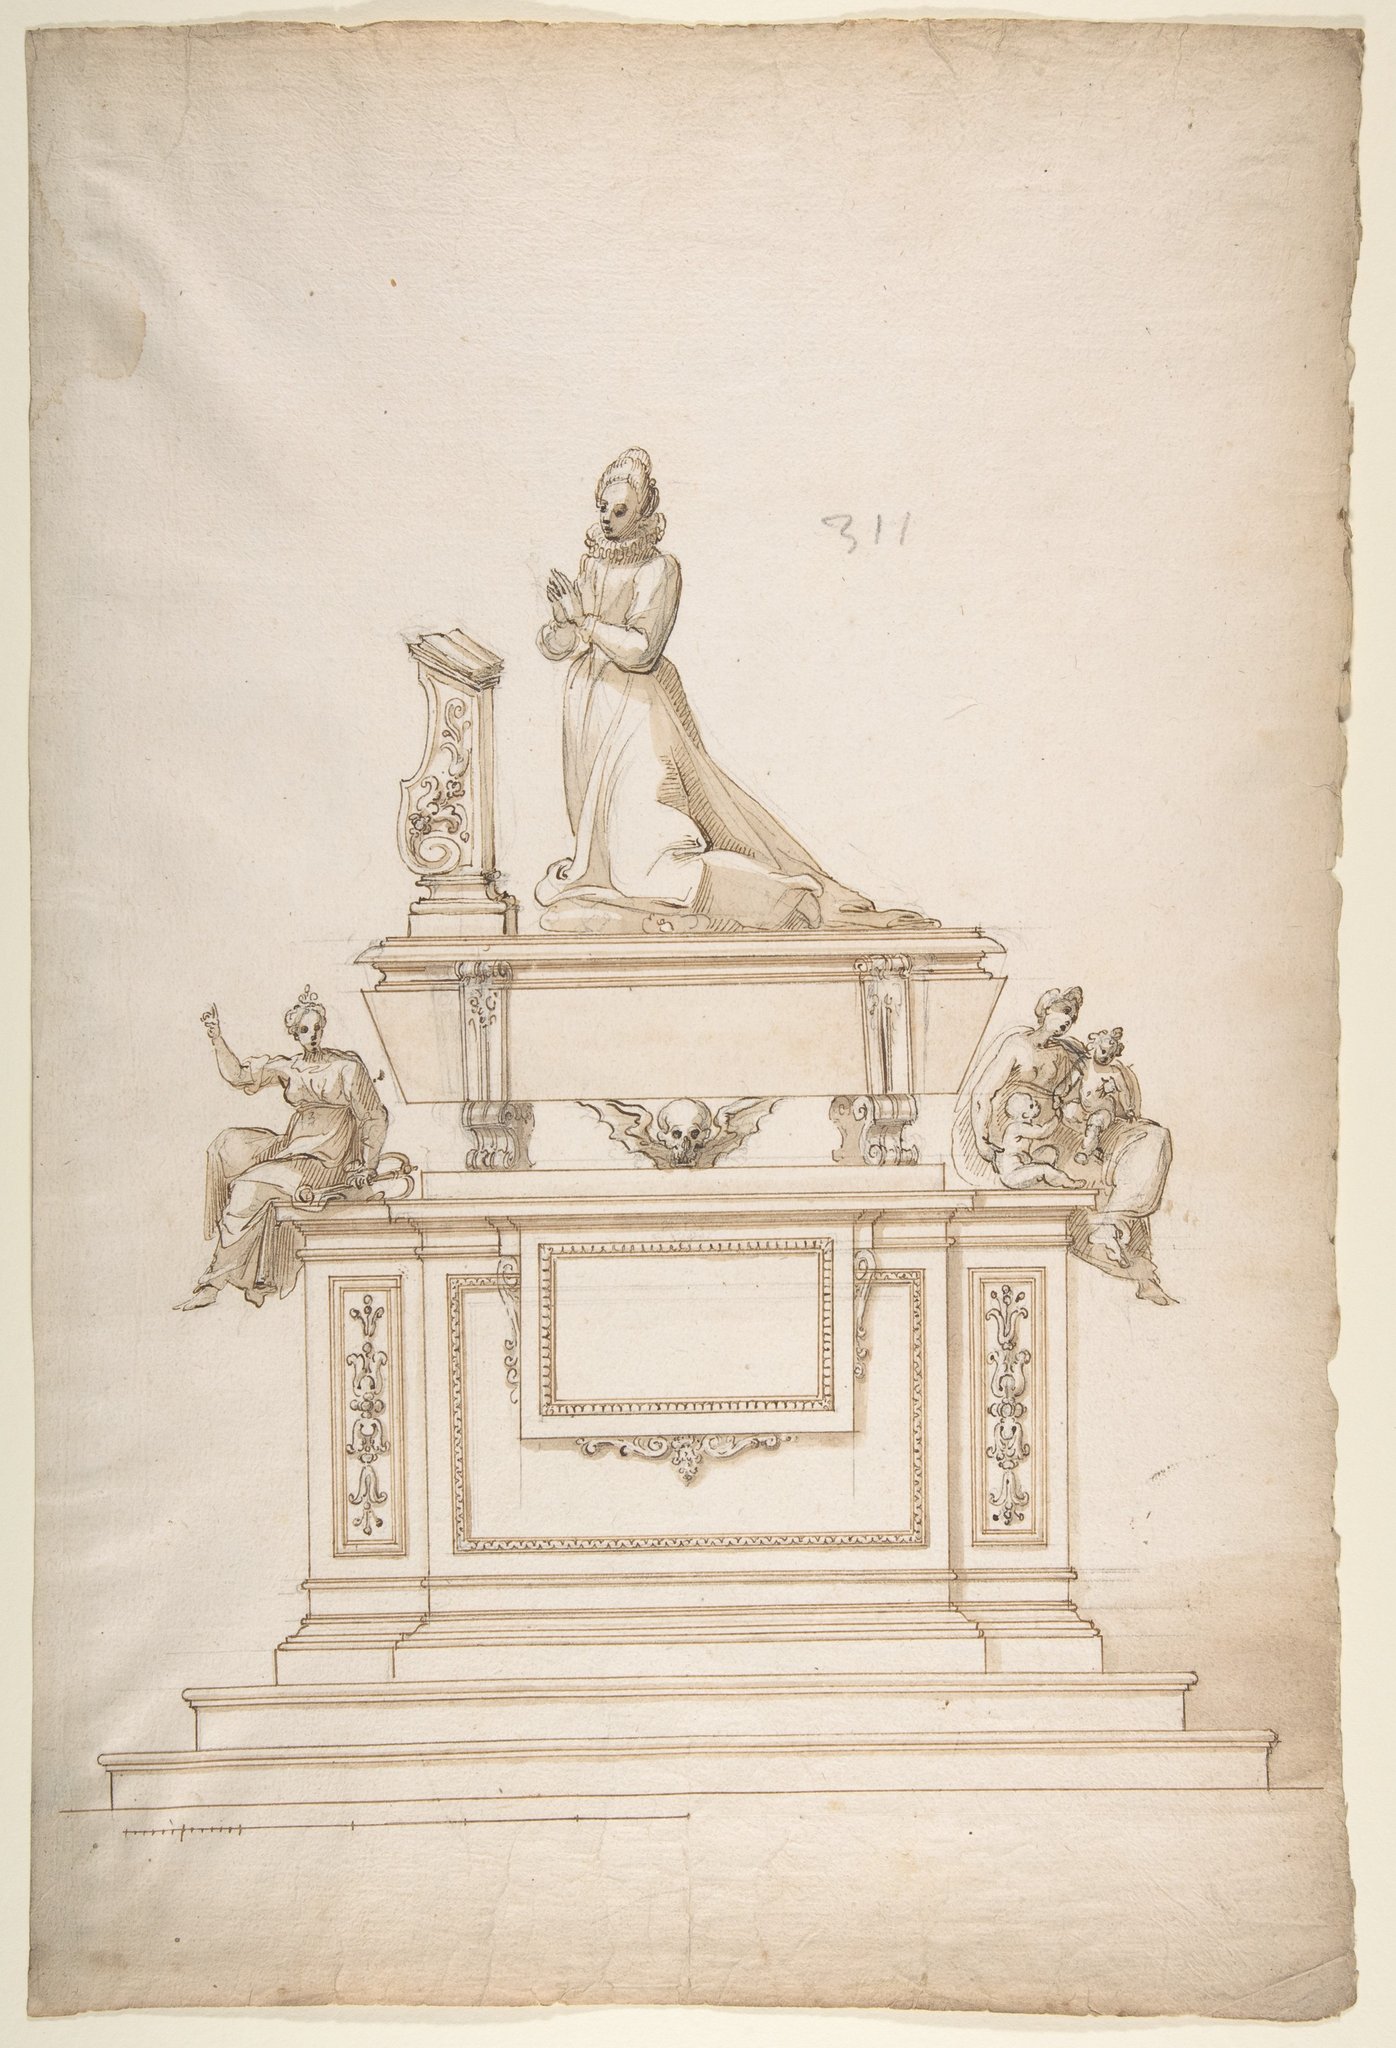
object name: drawing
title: Design for a Lady's Tomb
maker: anonymous, french, 16th century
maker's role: artist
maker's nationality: french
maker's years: 1500-1600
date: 1501-1600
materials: chalk, ink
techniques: brush, pen, wash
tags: tombs,skulls,women